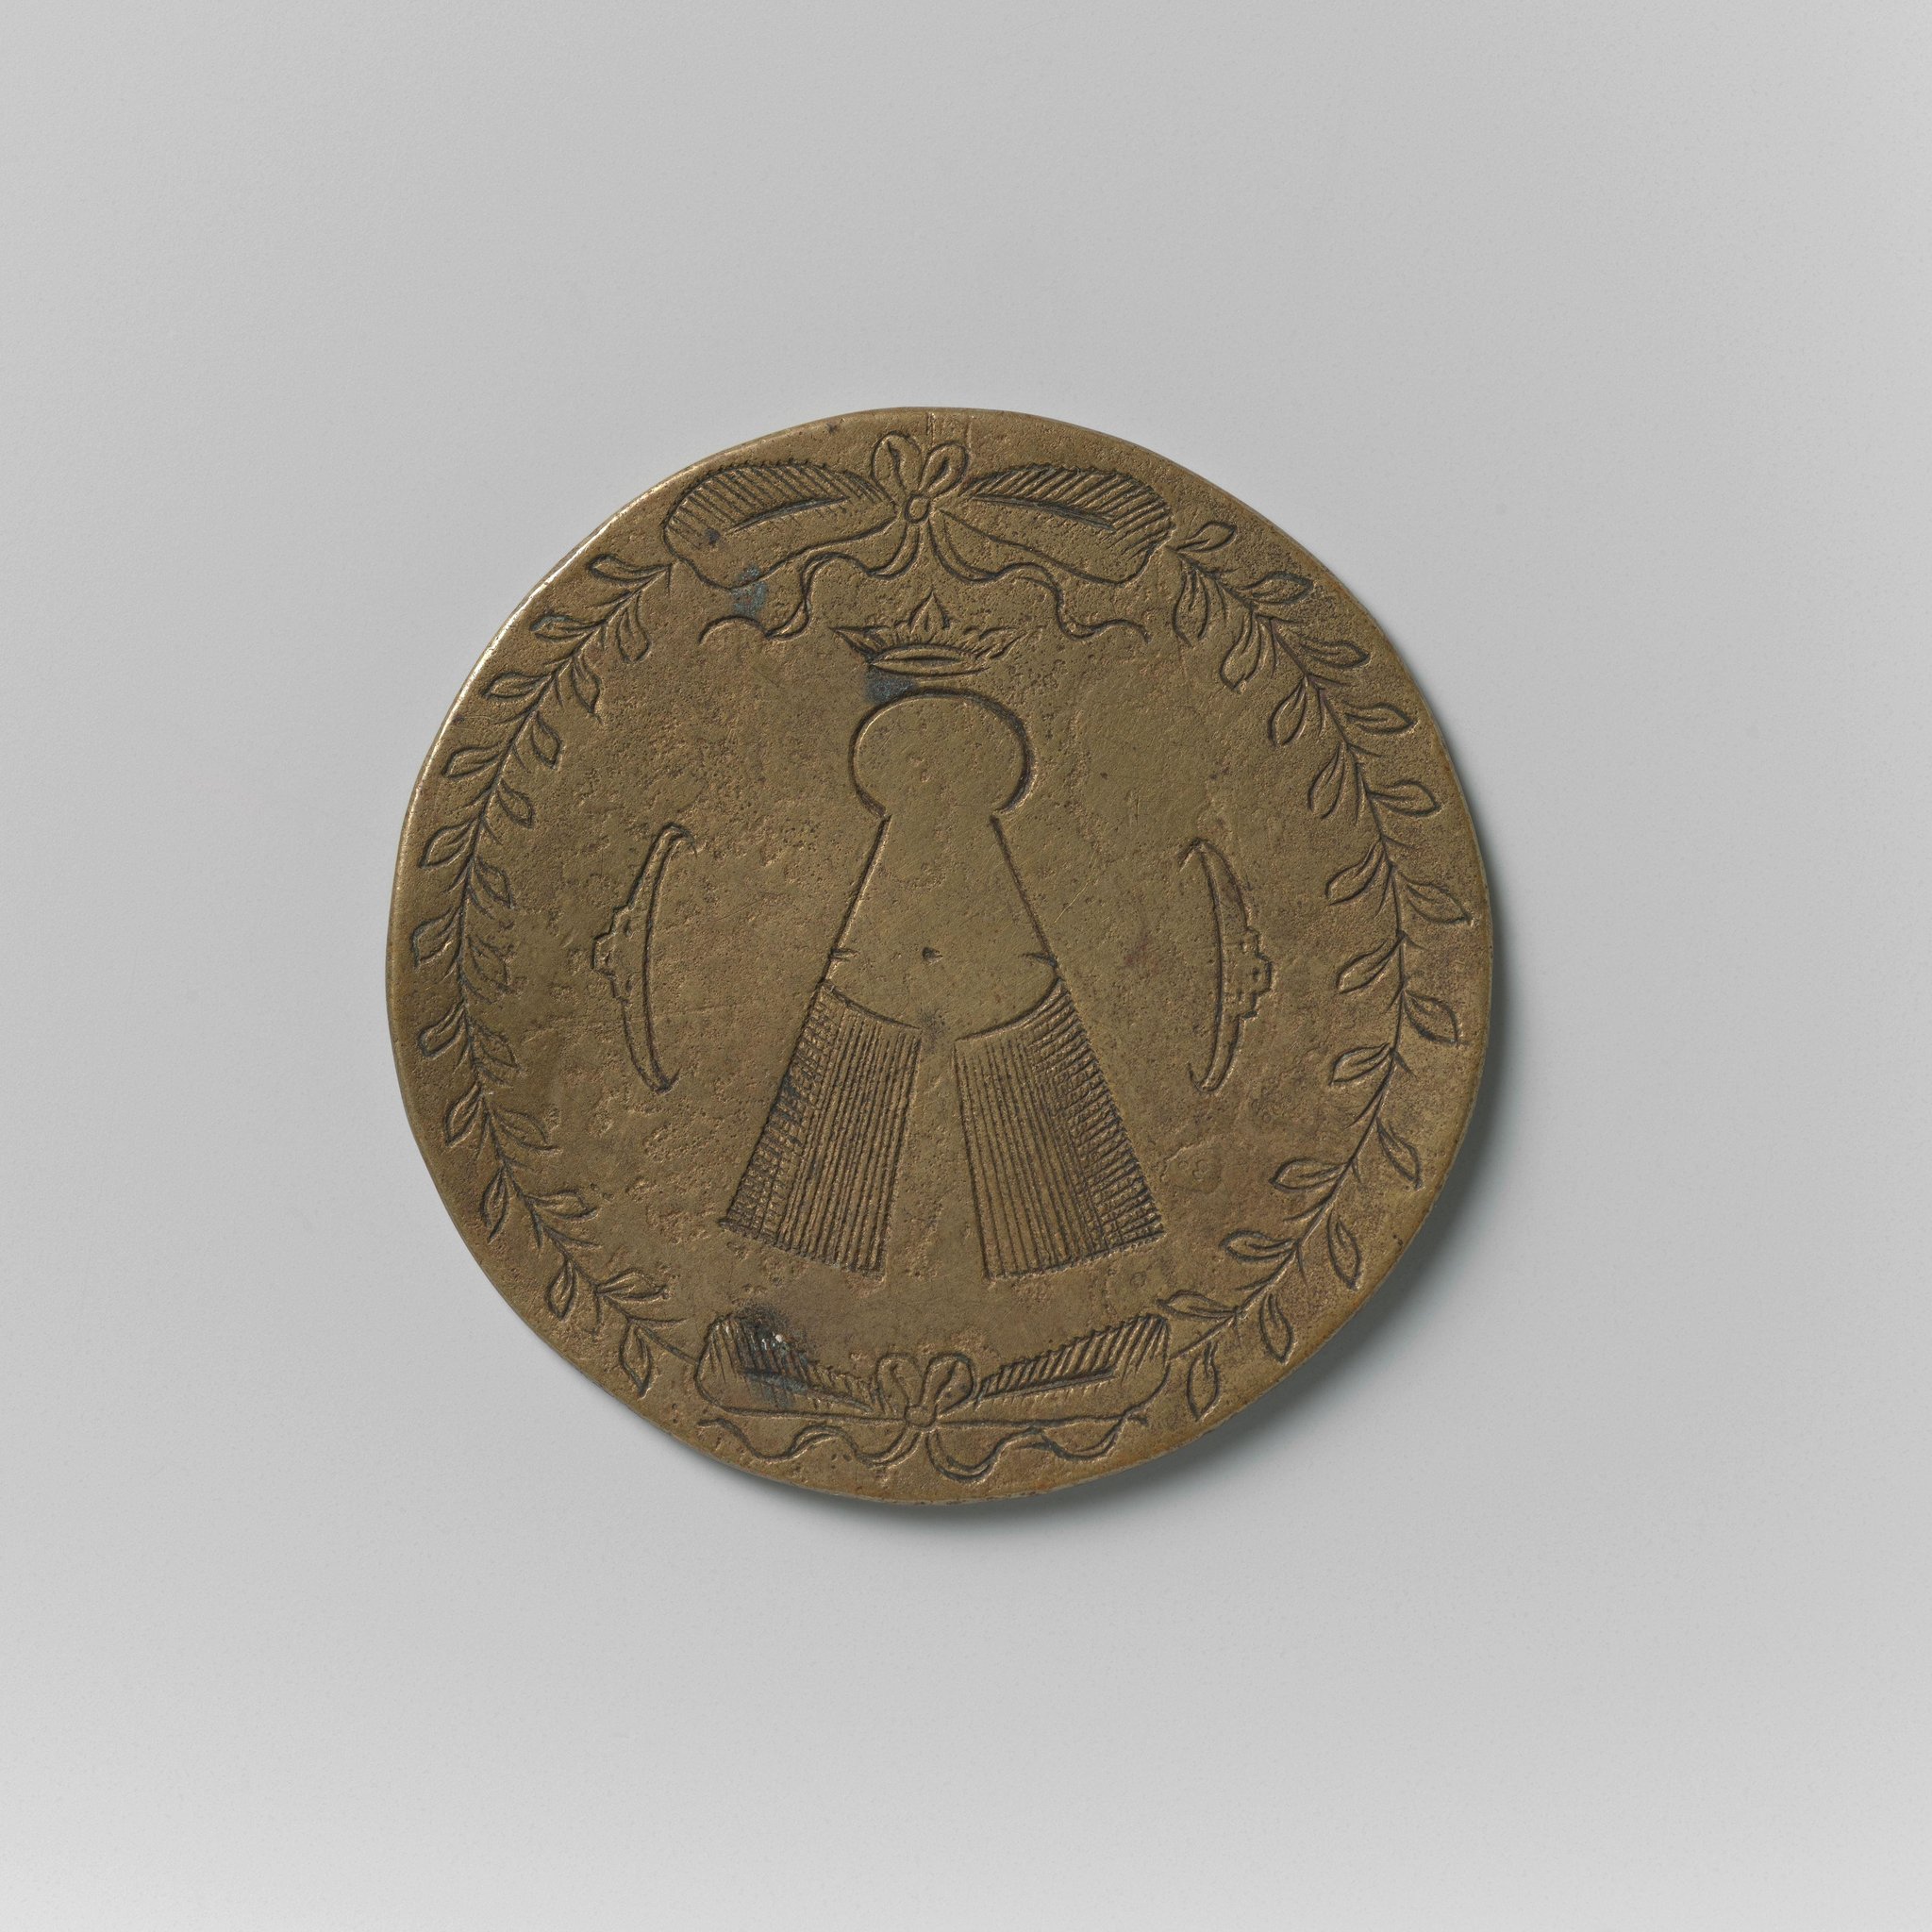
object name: medal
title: Presentiepenning van het Lakenbereiders- en Droogscheerdersgilde te Amsterdam 1653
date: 1653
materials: brass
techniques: engraving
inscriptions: inscription: ‘DIRCK IANS / VAN GROENIN / GEN’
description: Ronde plaat messing gegraveerd op de voorzijde binnen een krans een gekroonde droogscheerdersschaar, op de keerzijde binnen een krans een gekroond wapenschild Amsterdam met dragers boven een inscriptieruimte, op naam van Dirck Jans van Groeningen